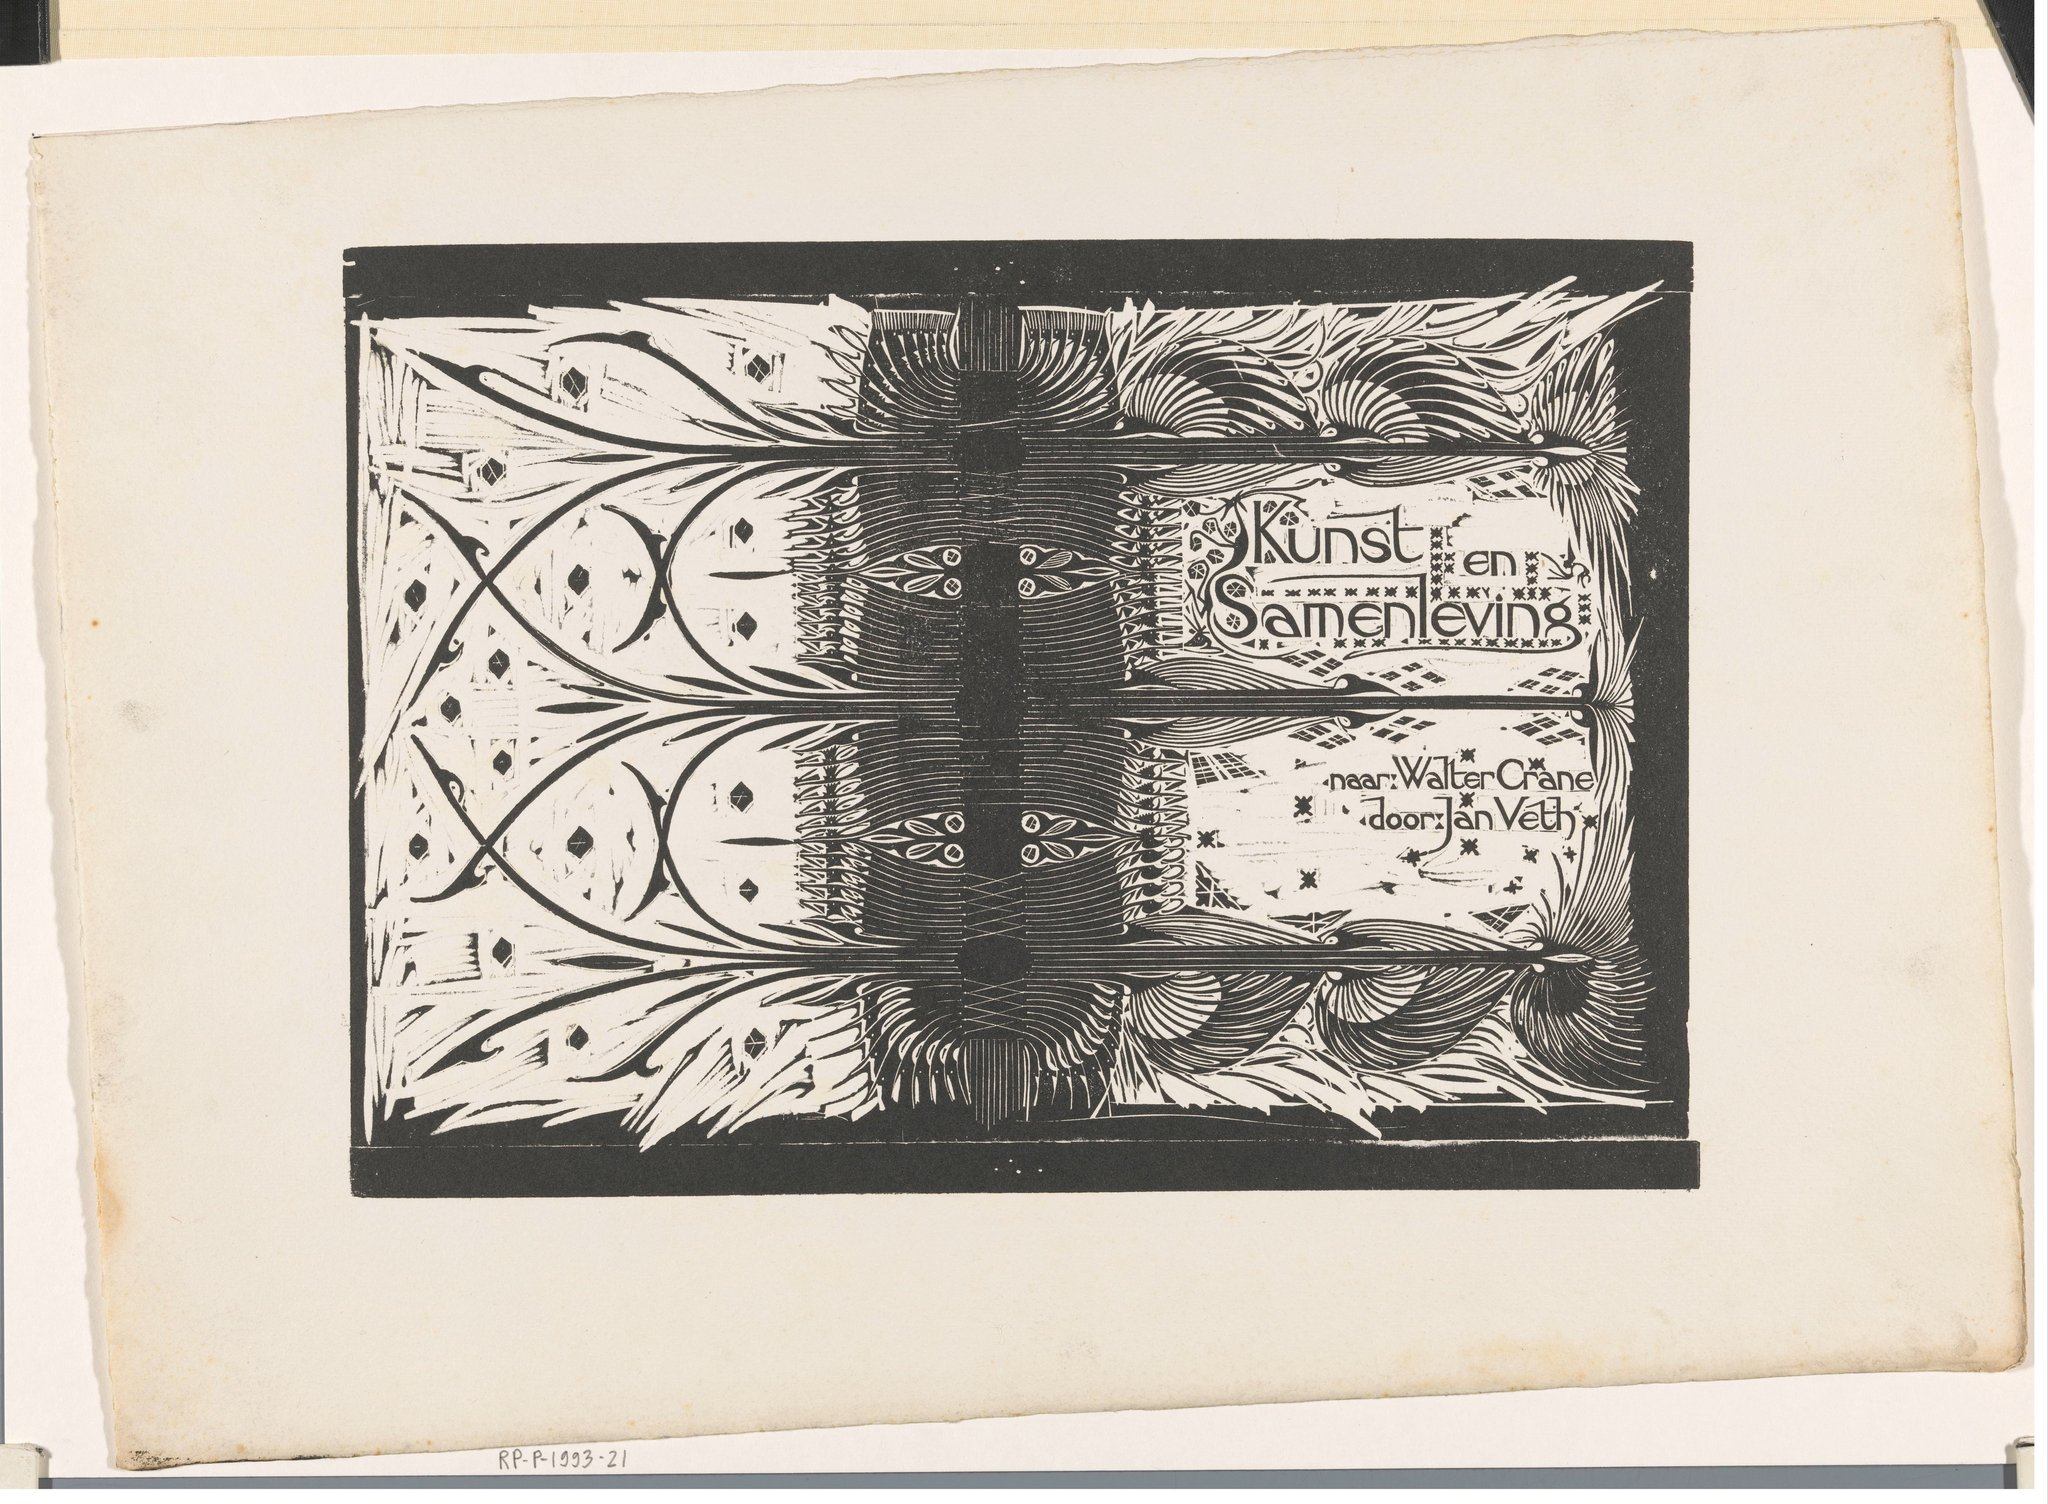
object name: print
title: Ontwerp voor de boekomslag van de ingenaaide editie van 'Kunst en samenleving'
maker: gerrit willem dijsselhof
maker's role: designer, draughtsman, print maker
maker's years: 1866-1924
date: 1893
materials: paper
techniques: woodcut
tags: dordrecht, amsterdam, painter, jan veth, liverpool, walter crane, ornament derived from animal forms, ornamental birds: peacock (+ feathers)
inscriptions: collector's mark: Lugt 2760, collector's mark: Lugt 2228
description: Een boekomslag met drie pauwenveren die zich horizontaal uitstrekken over de voor- en achterzijde. De pennen van de veren zijn kruislings gerangschikt op de achterzijde.